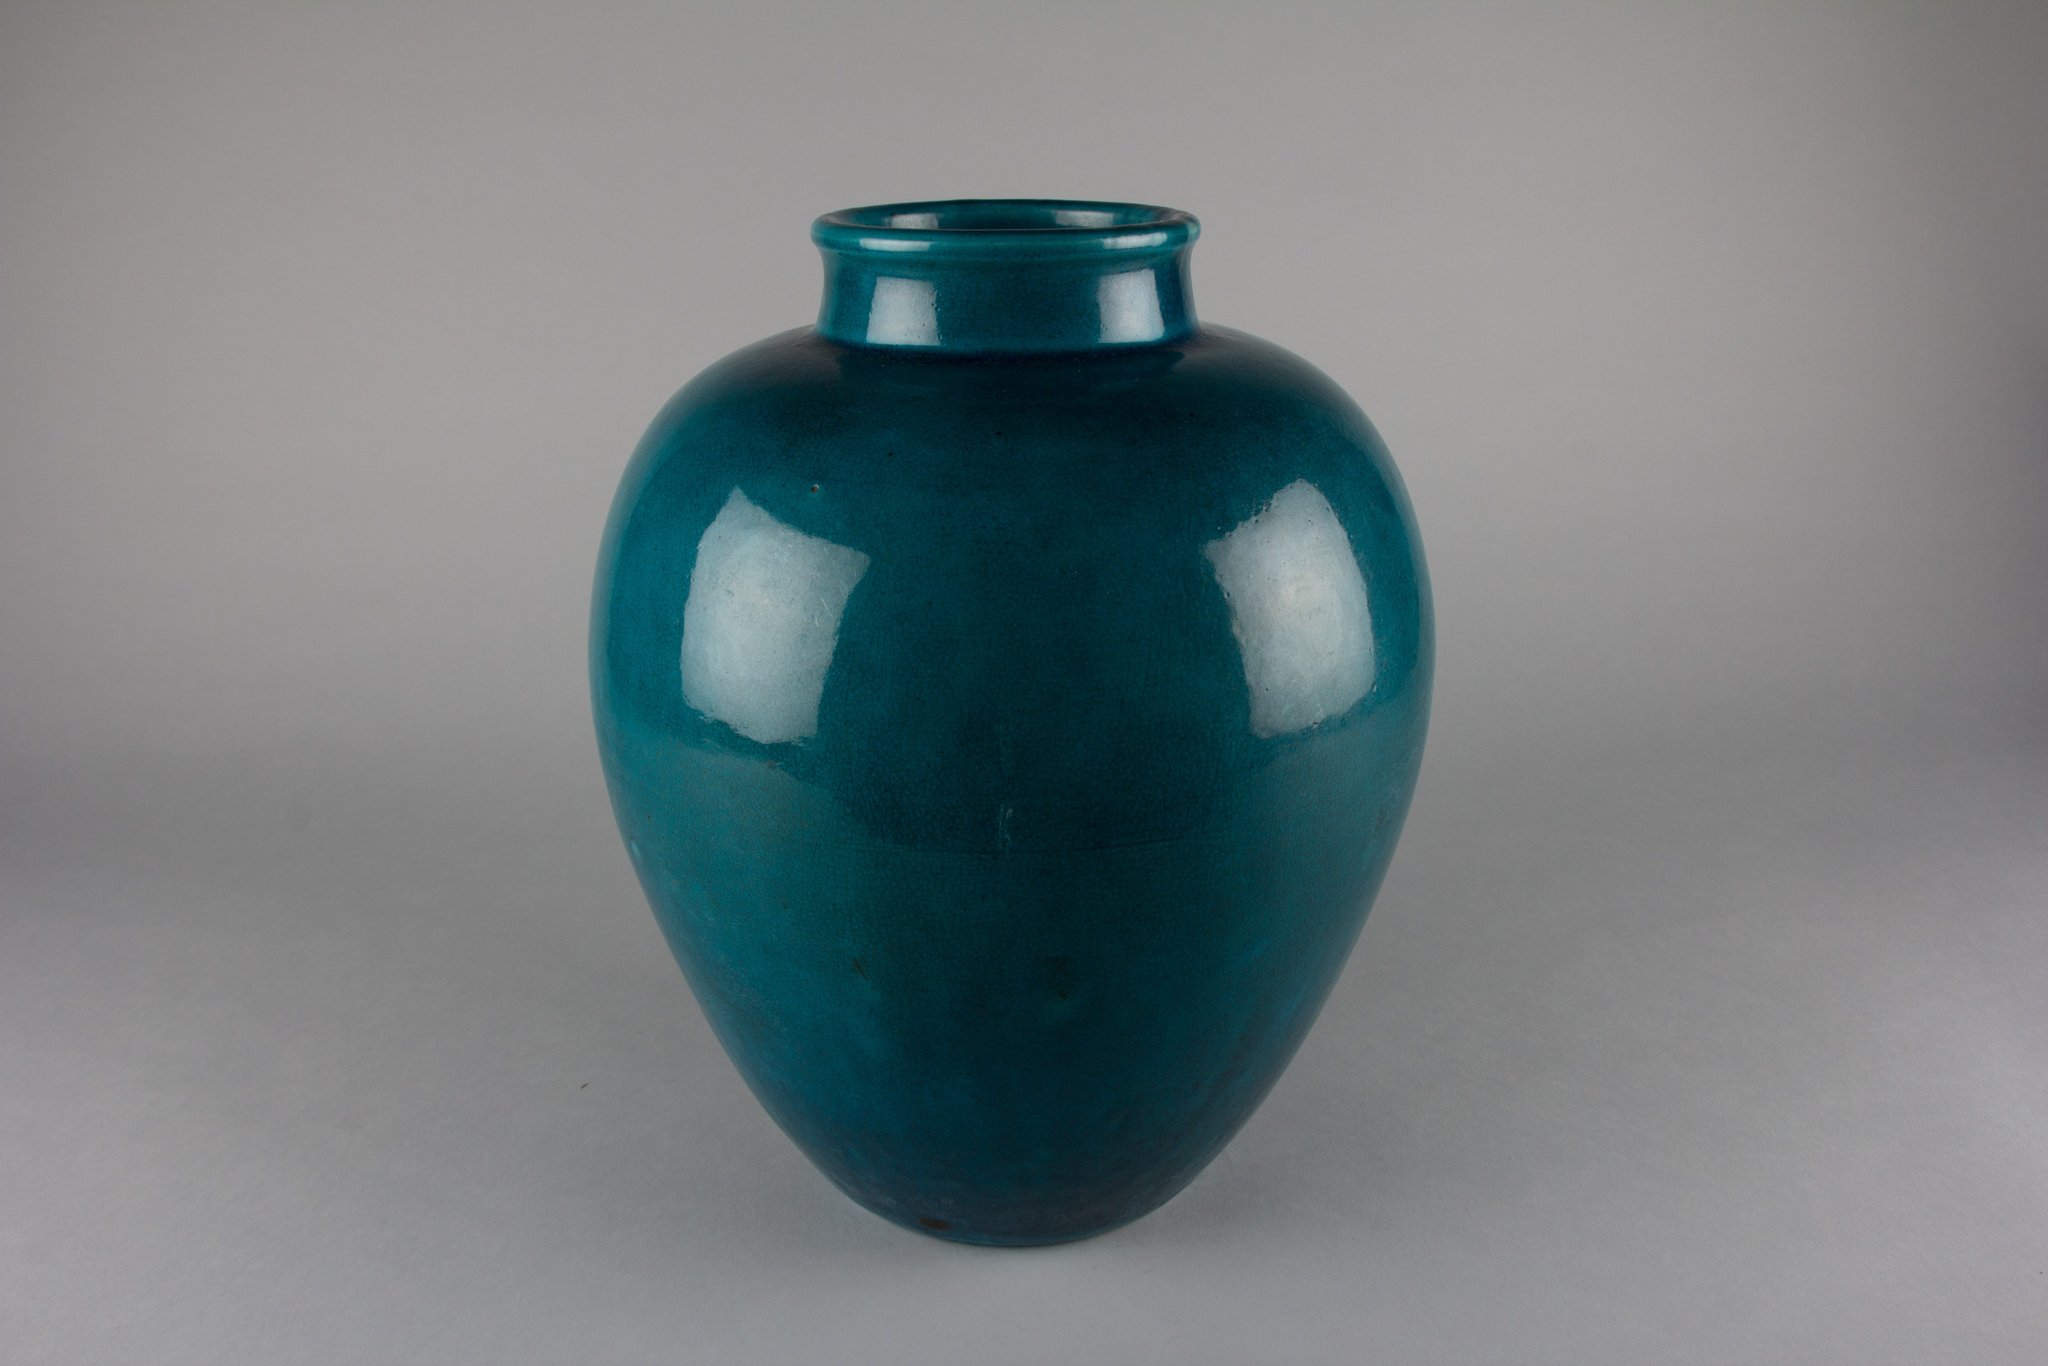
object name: jar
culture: chinese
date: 1701-1800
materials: glaze, porcelain